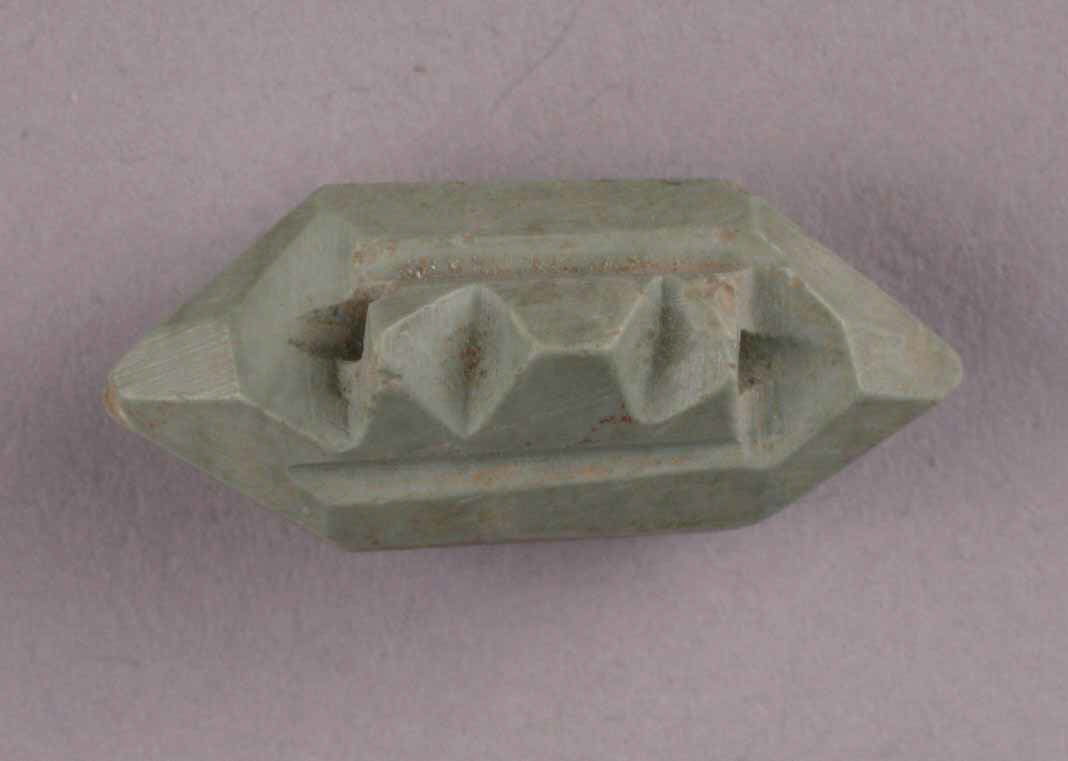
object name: bead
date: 801-1000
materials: stone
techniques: carving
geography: iran